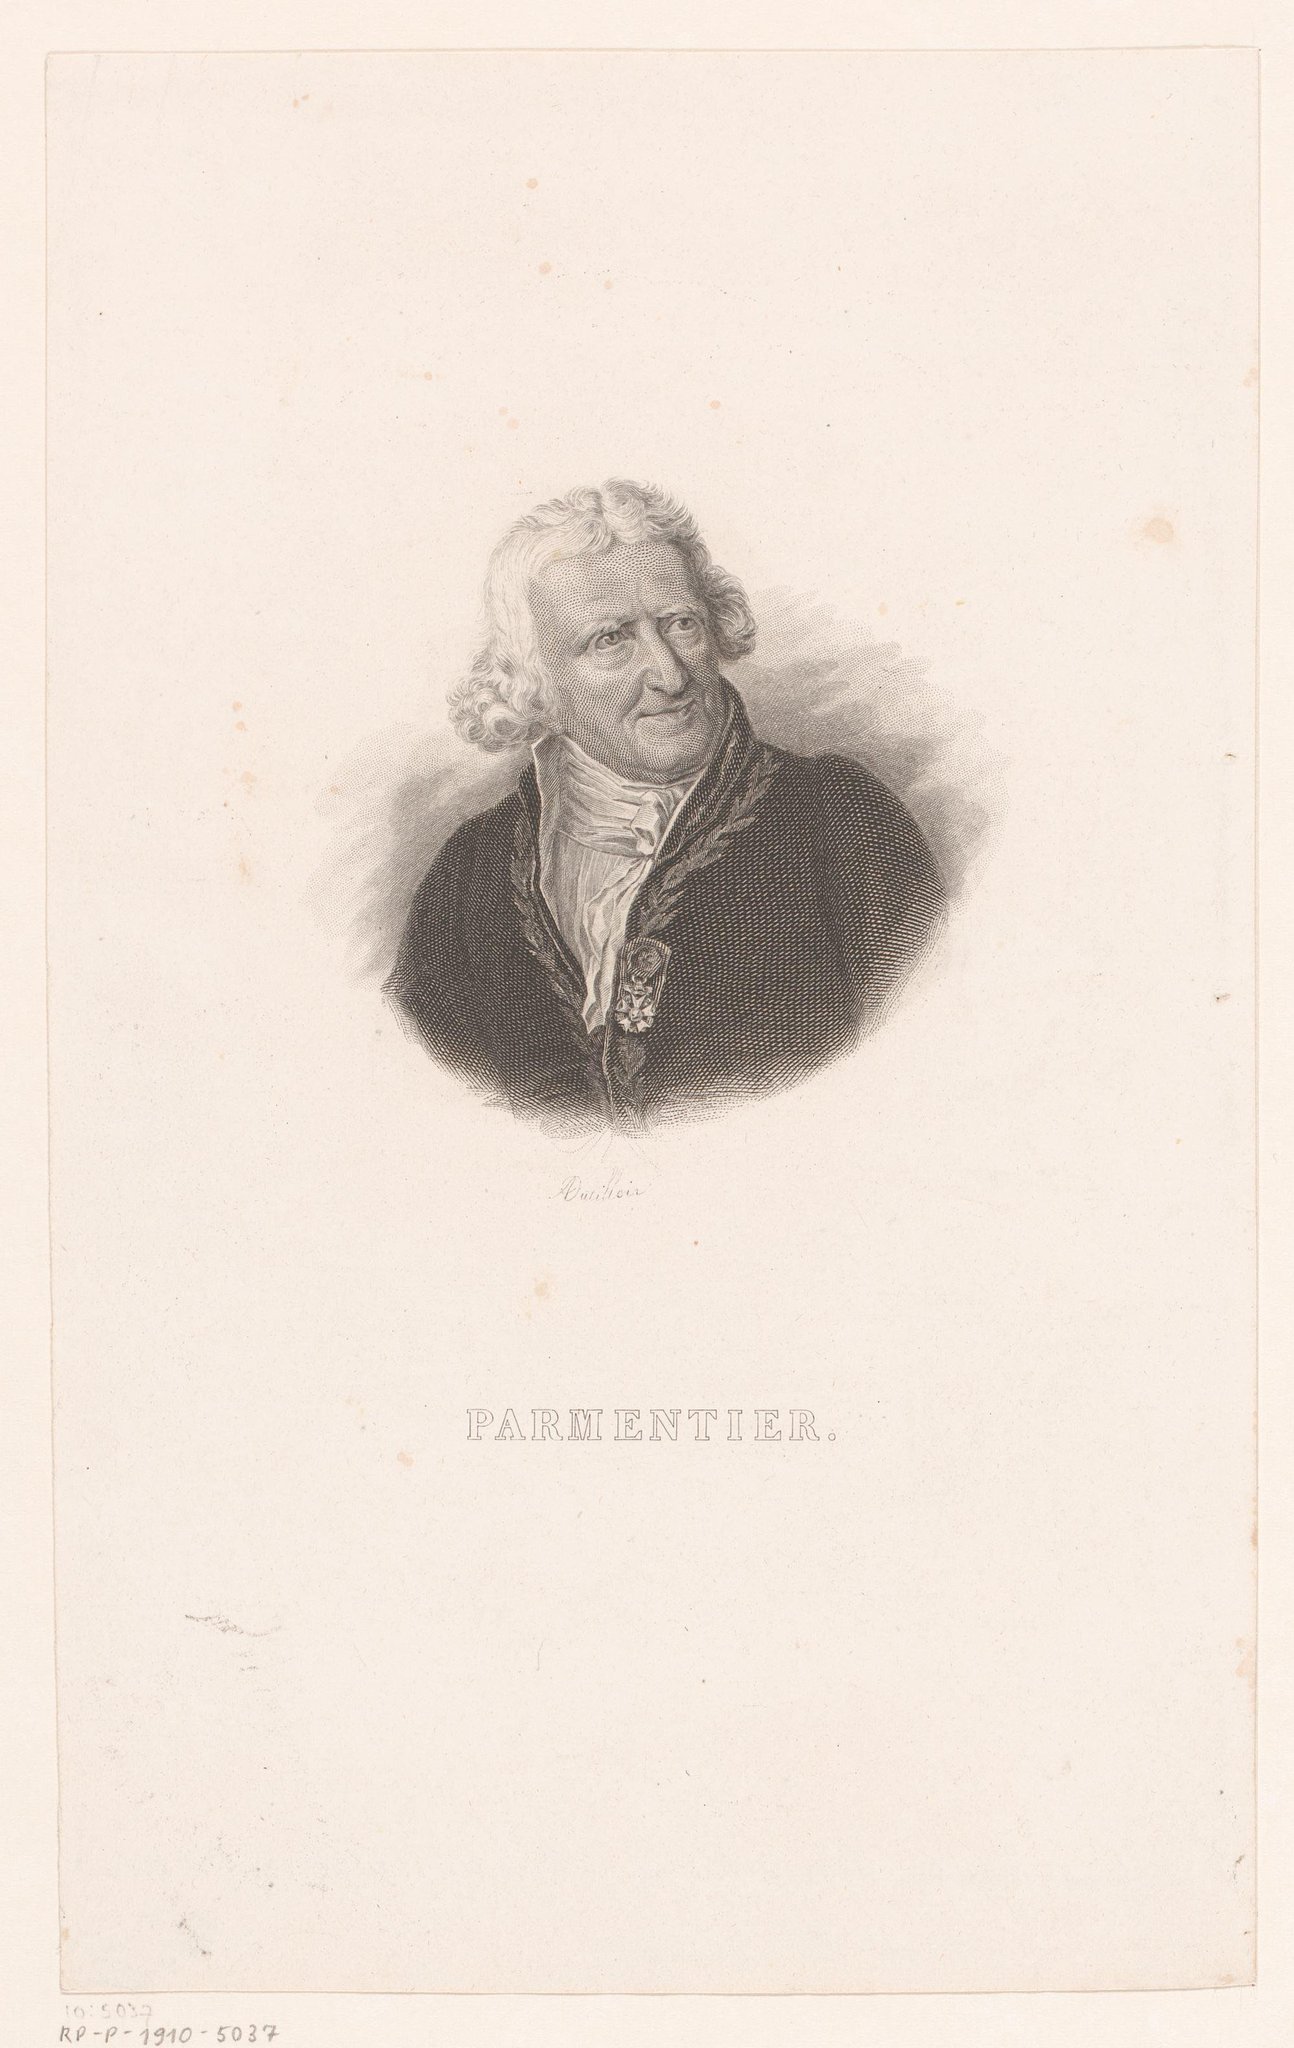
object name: print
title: Parmentier.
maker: auguste dutillois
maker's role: print maker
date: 1840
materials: paper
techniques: engraving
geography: france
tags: paris, pharmacist, druggist, apothecary; pharmacy, drugstore, dispensing chemist, historical persons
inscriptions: collector's mark: Lugt 2228